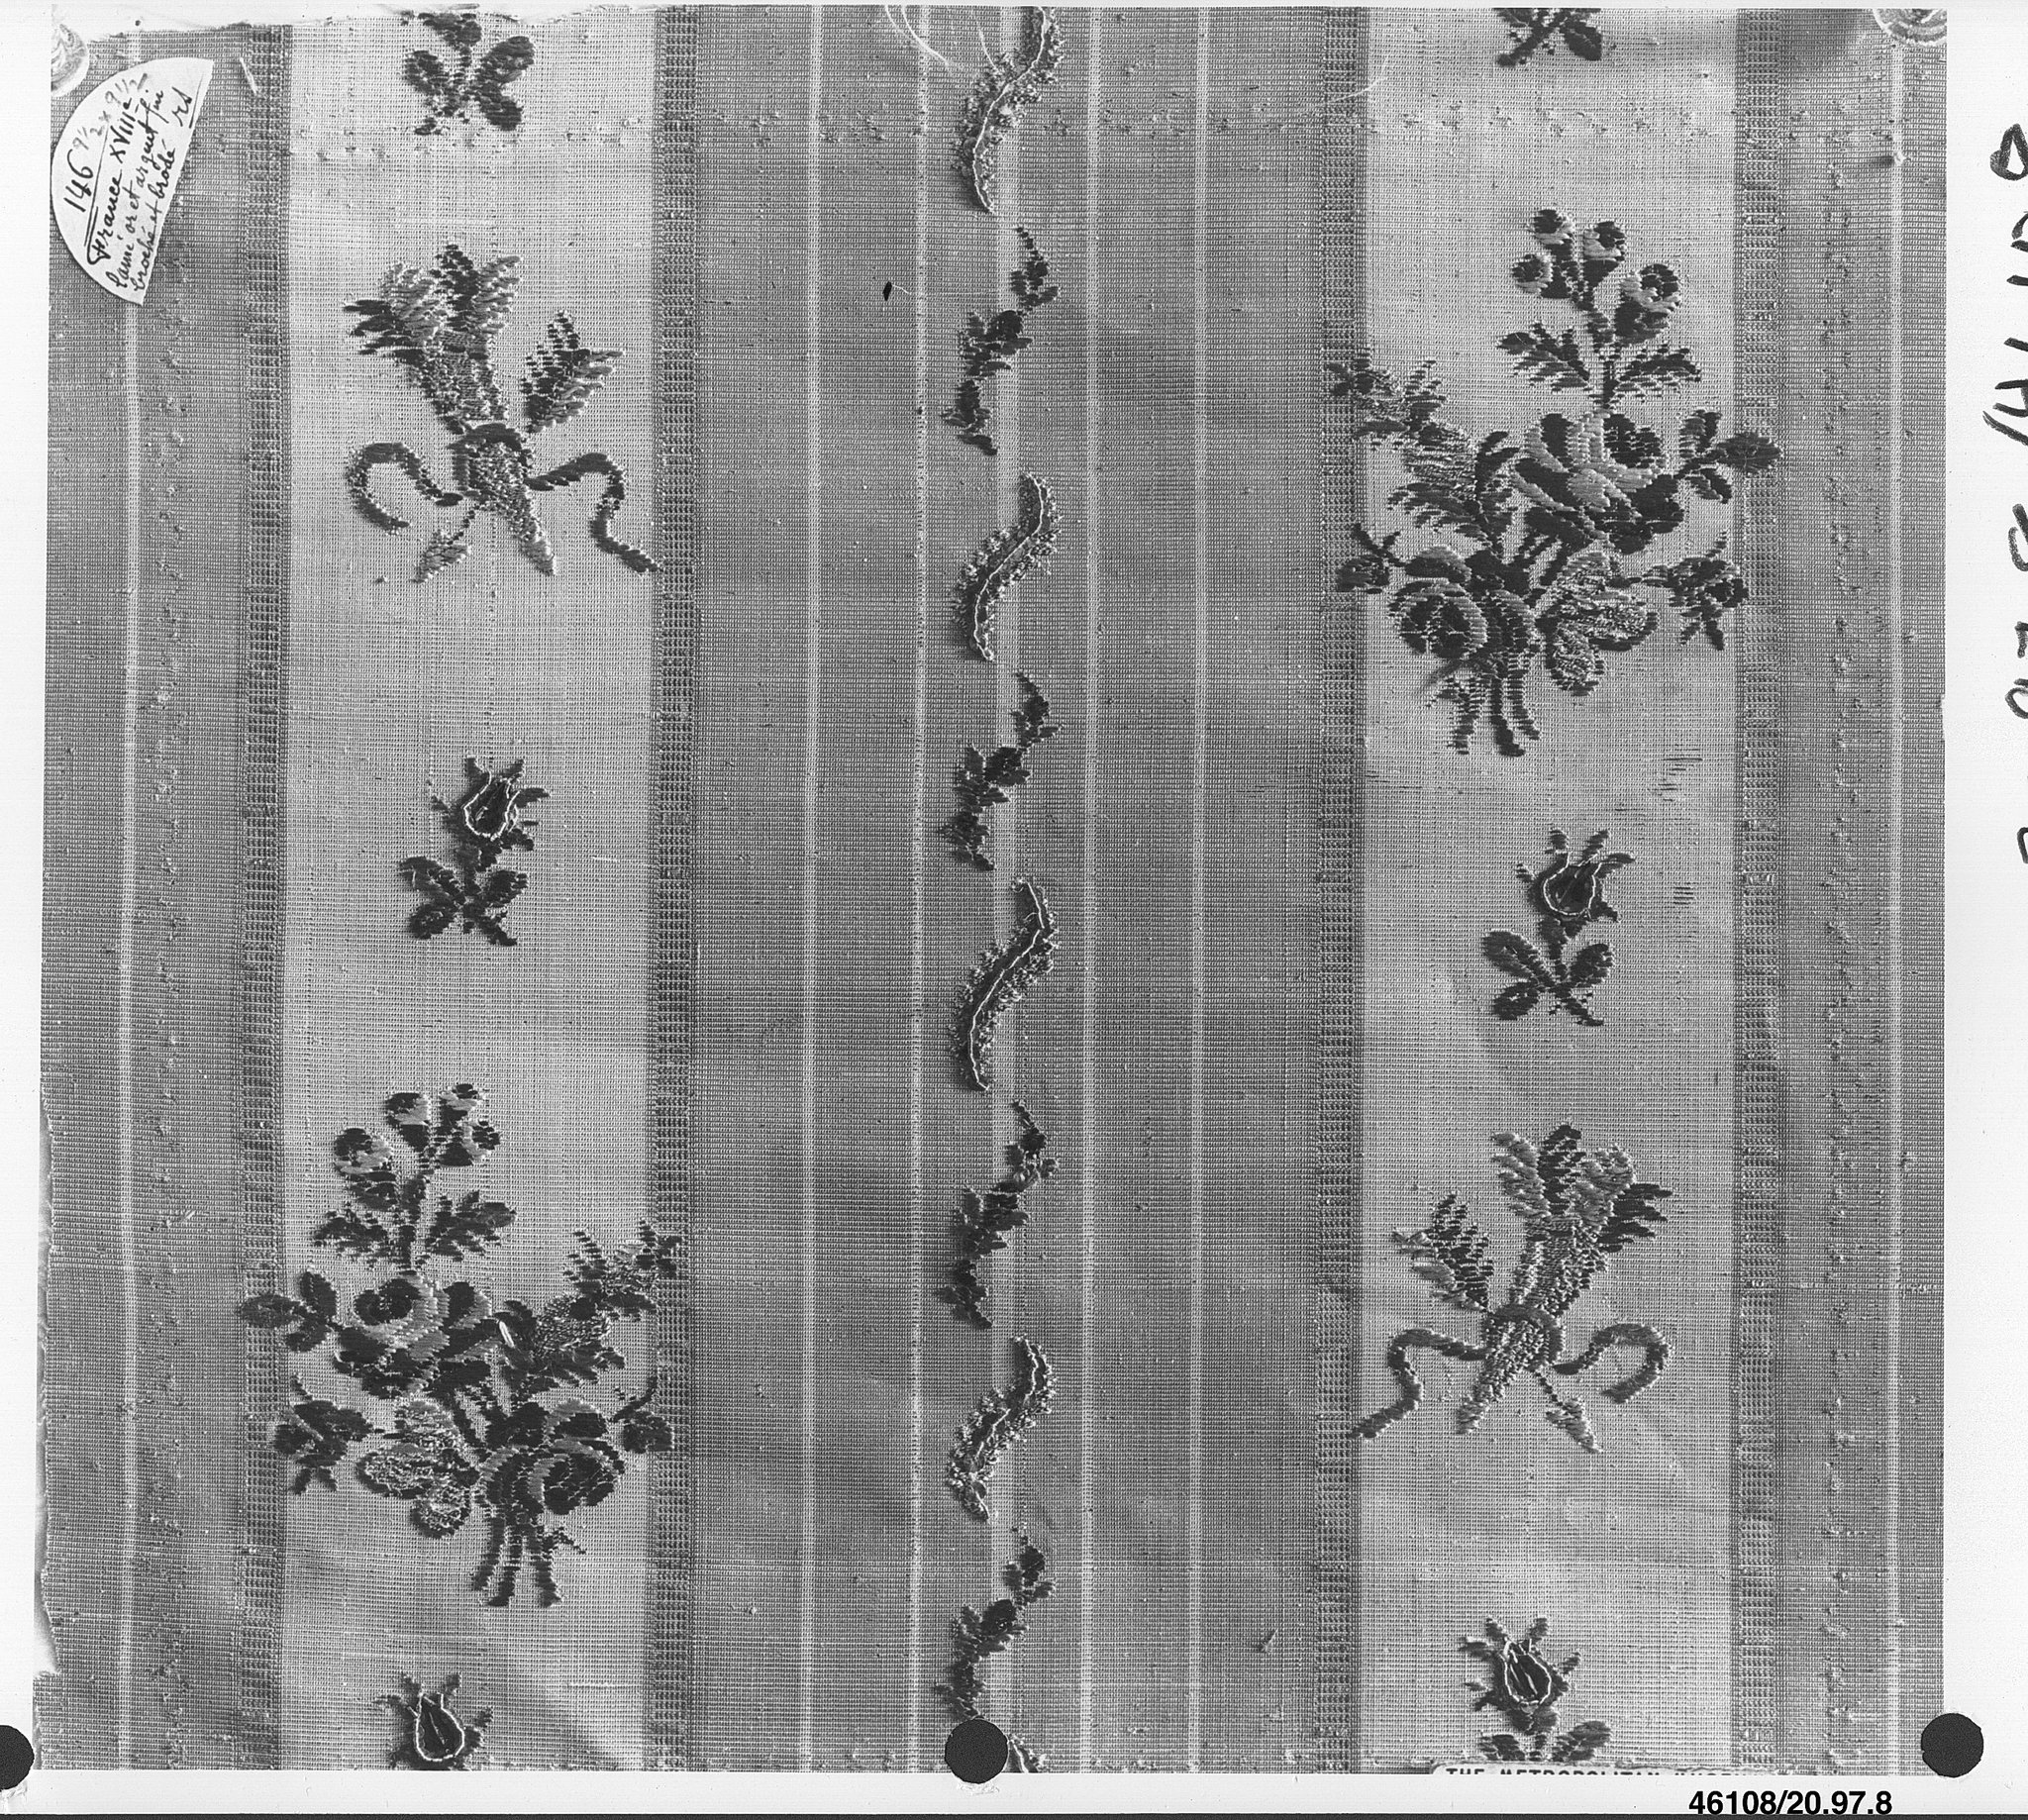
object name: piece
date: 1774-1792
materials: silk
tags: flowers,leaves